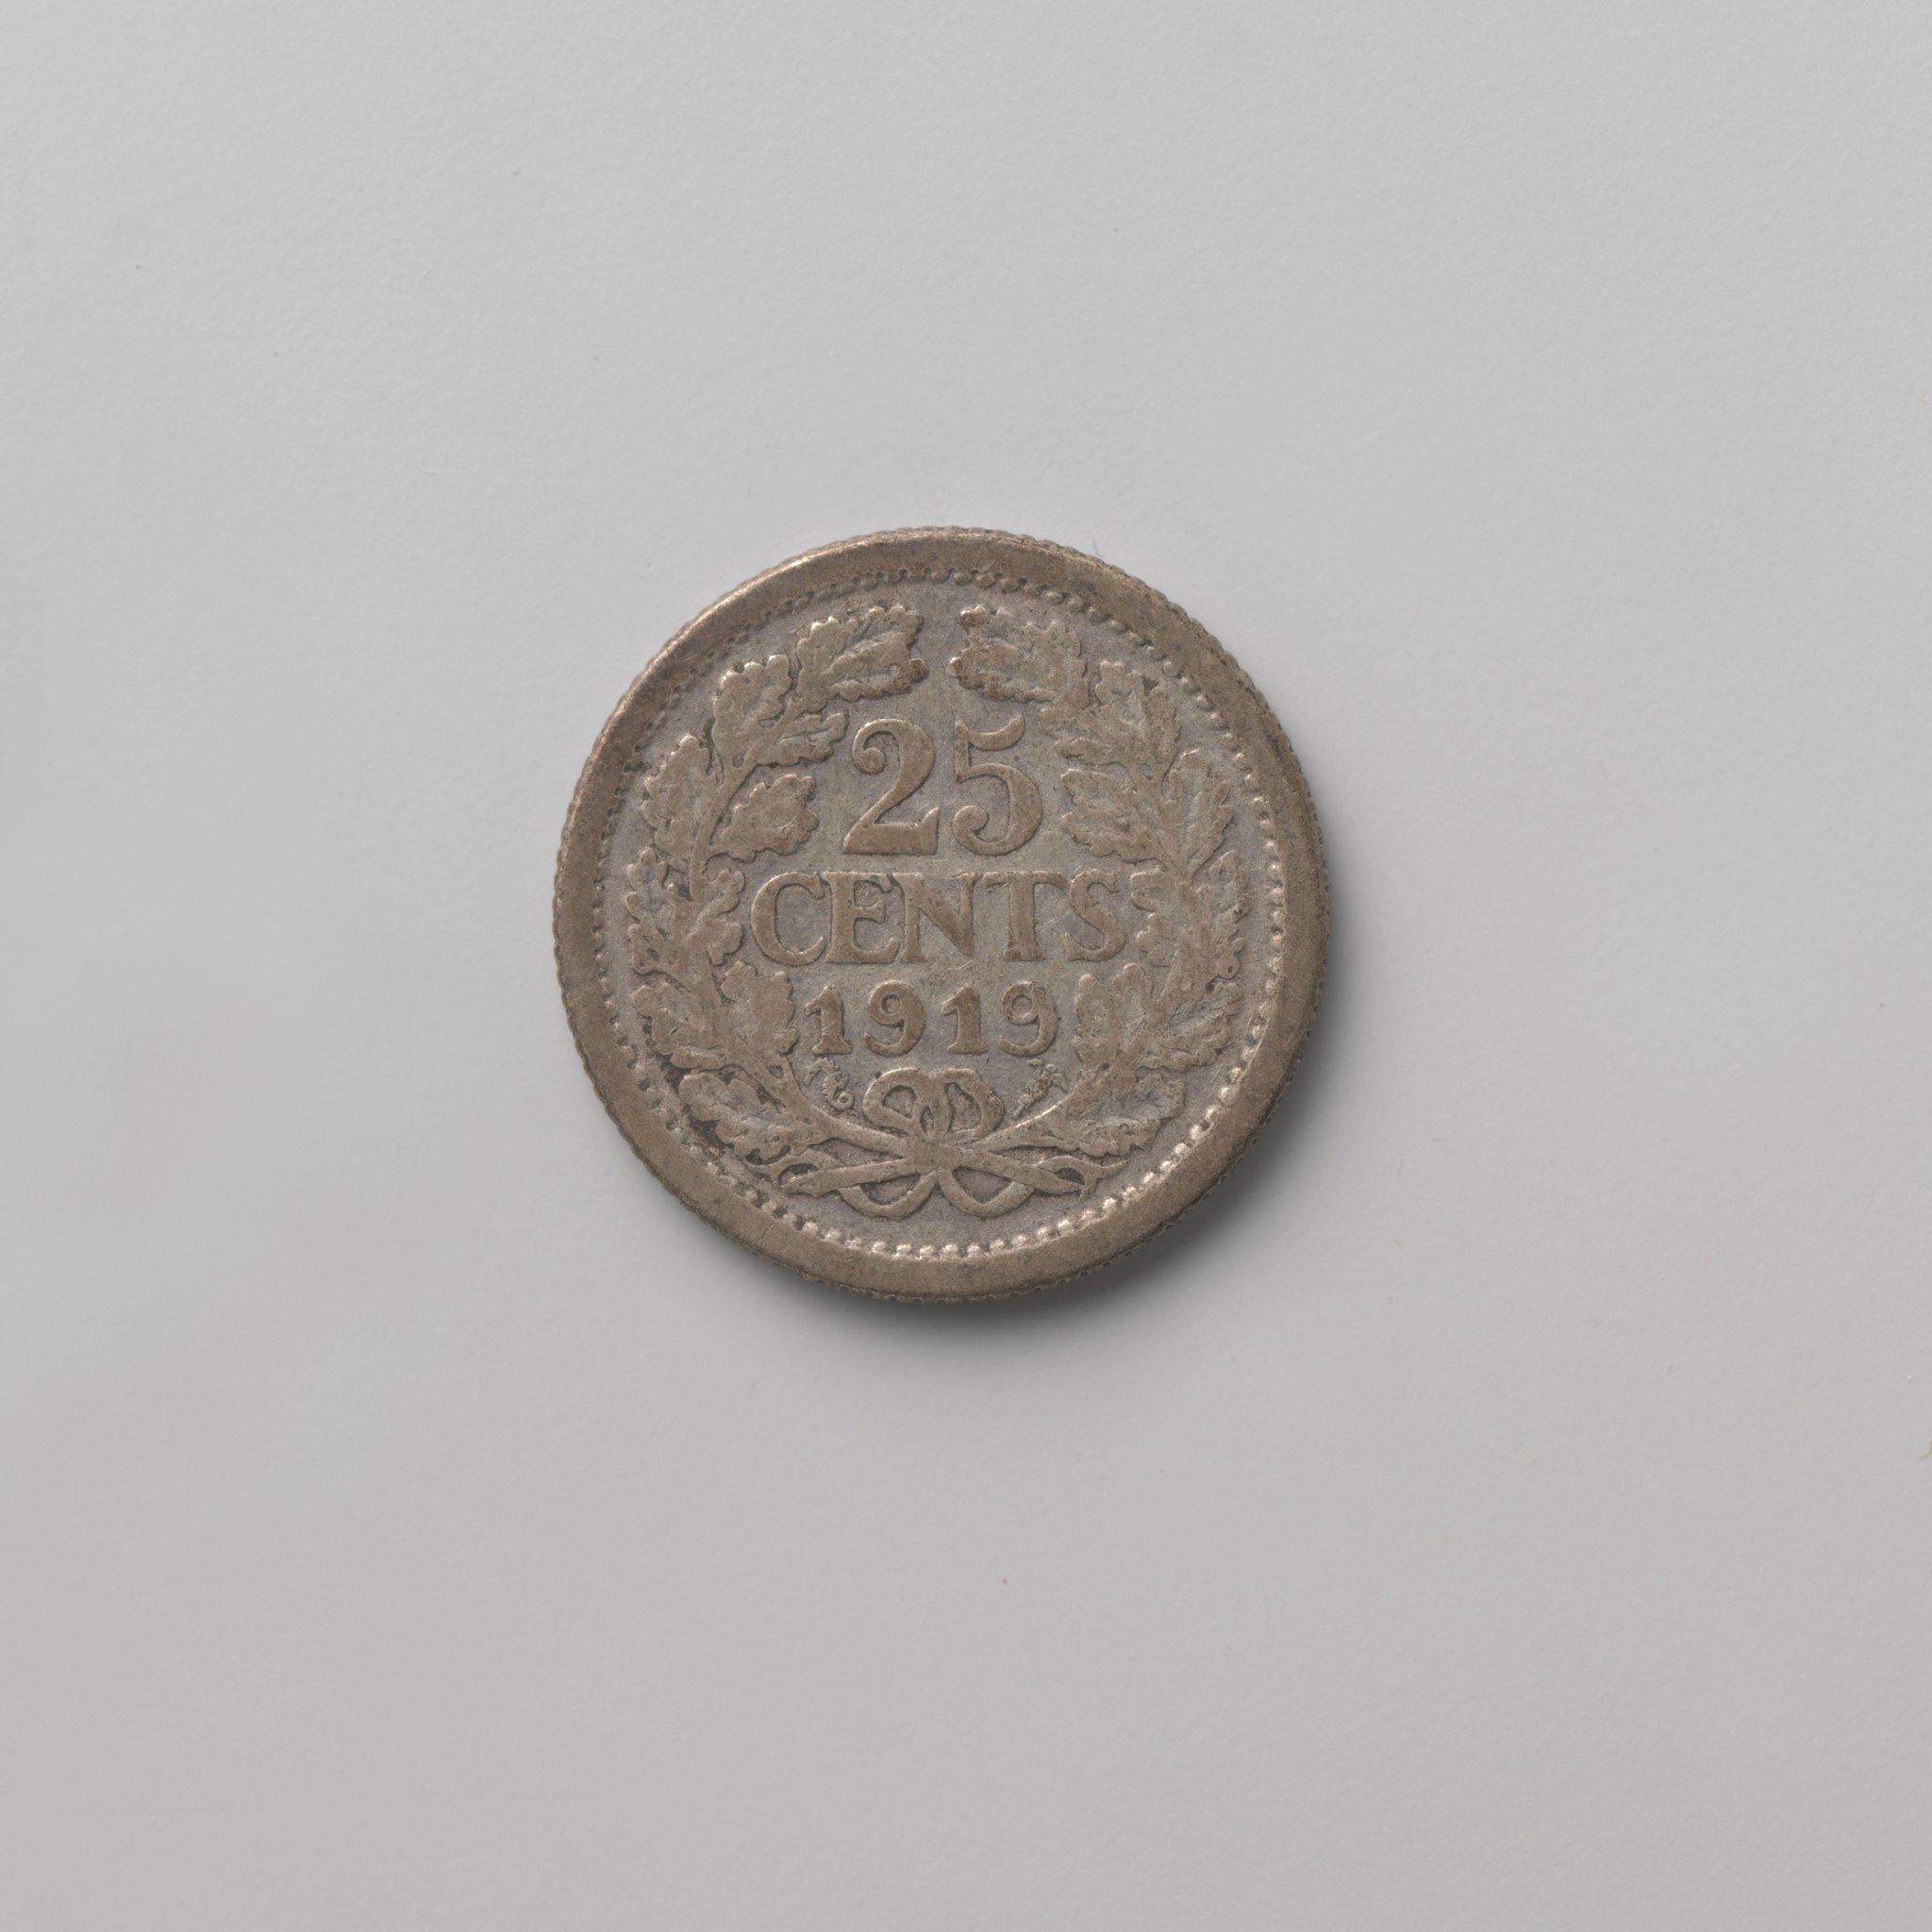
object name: coin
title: Nederland, 25 cent,1919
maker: wilhelmina of the netherlands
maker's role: print maker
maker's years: 1880-1962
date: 1919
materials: silver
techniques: striking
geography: utrecht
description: Zilveren munt. Voorzijde: gedrapeerd borstbeeld naar links. Keerzijde: binnen twee samengebonden eiketakken waarde-aanduiding 25 cents en jaartal. Kartelrand.